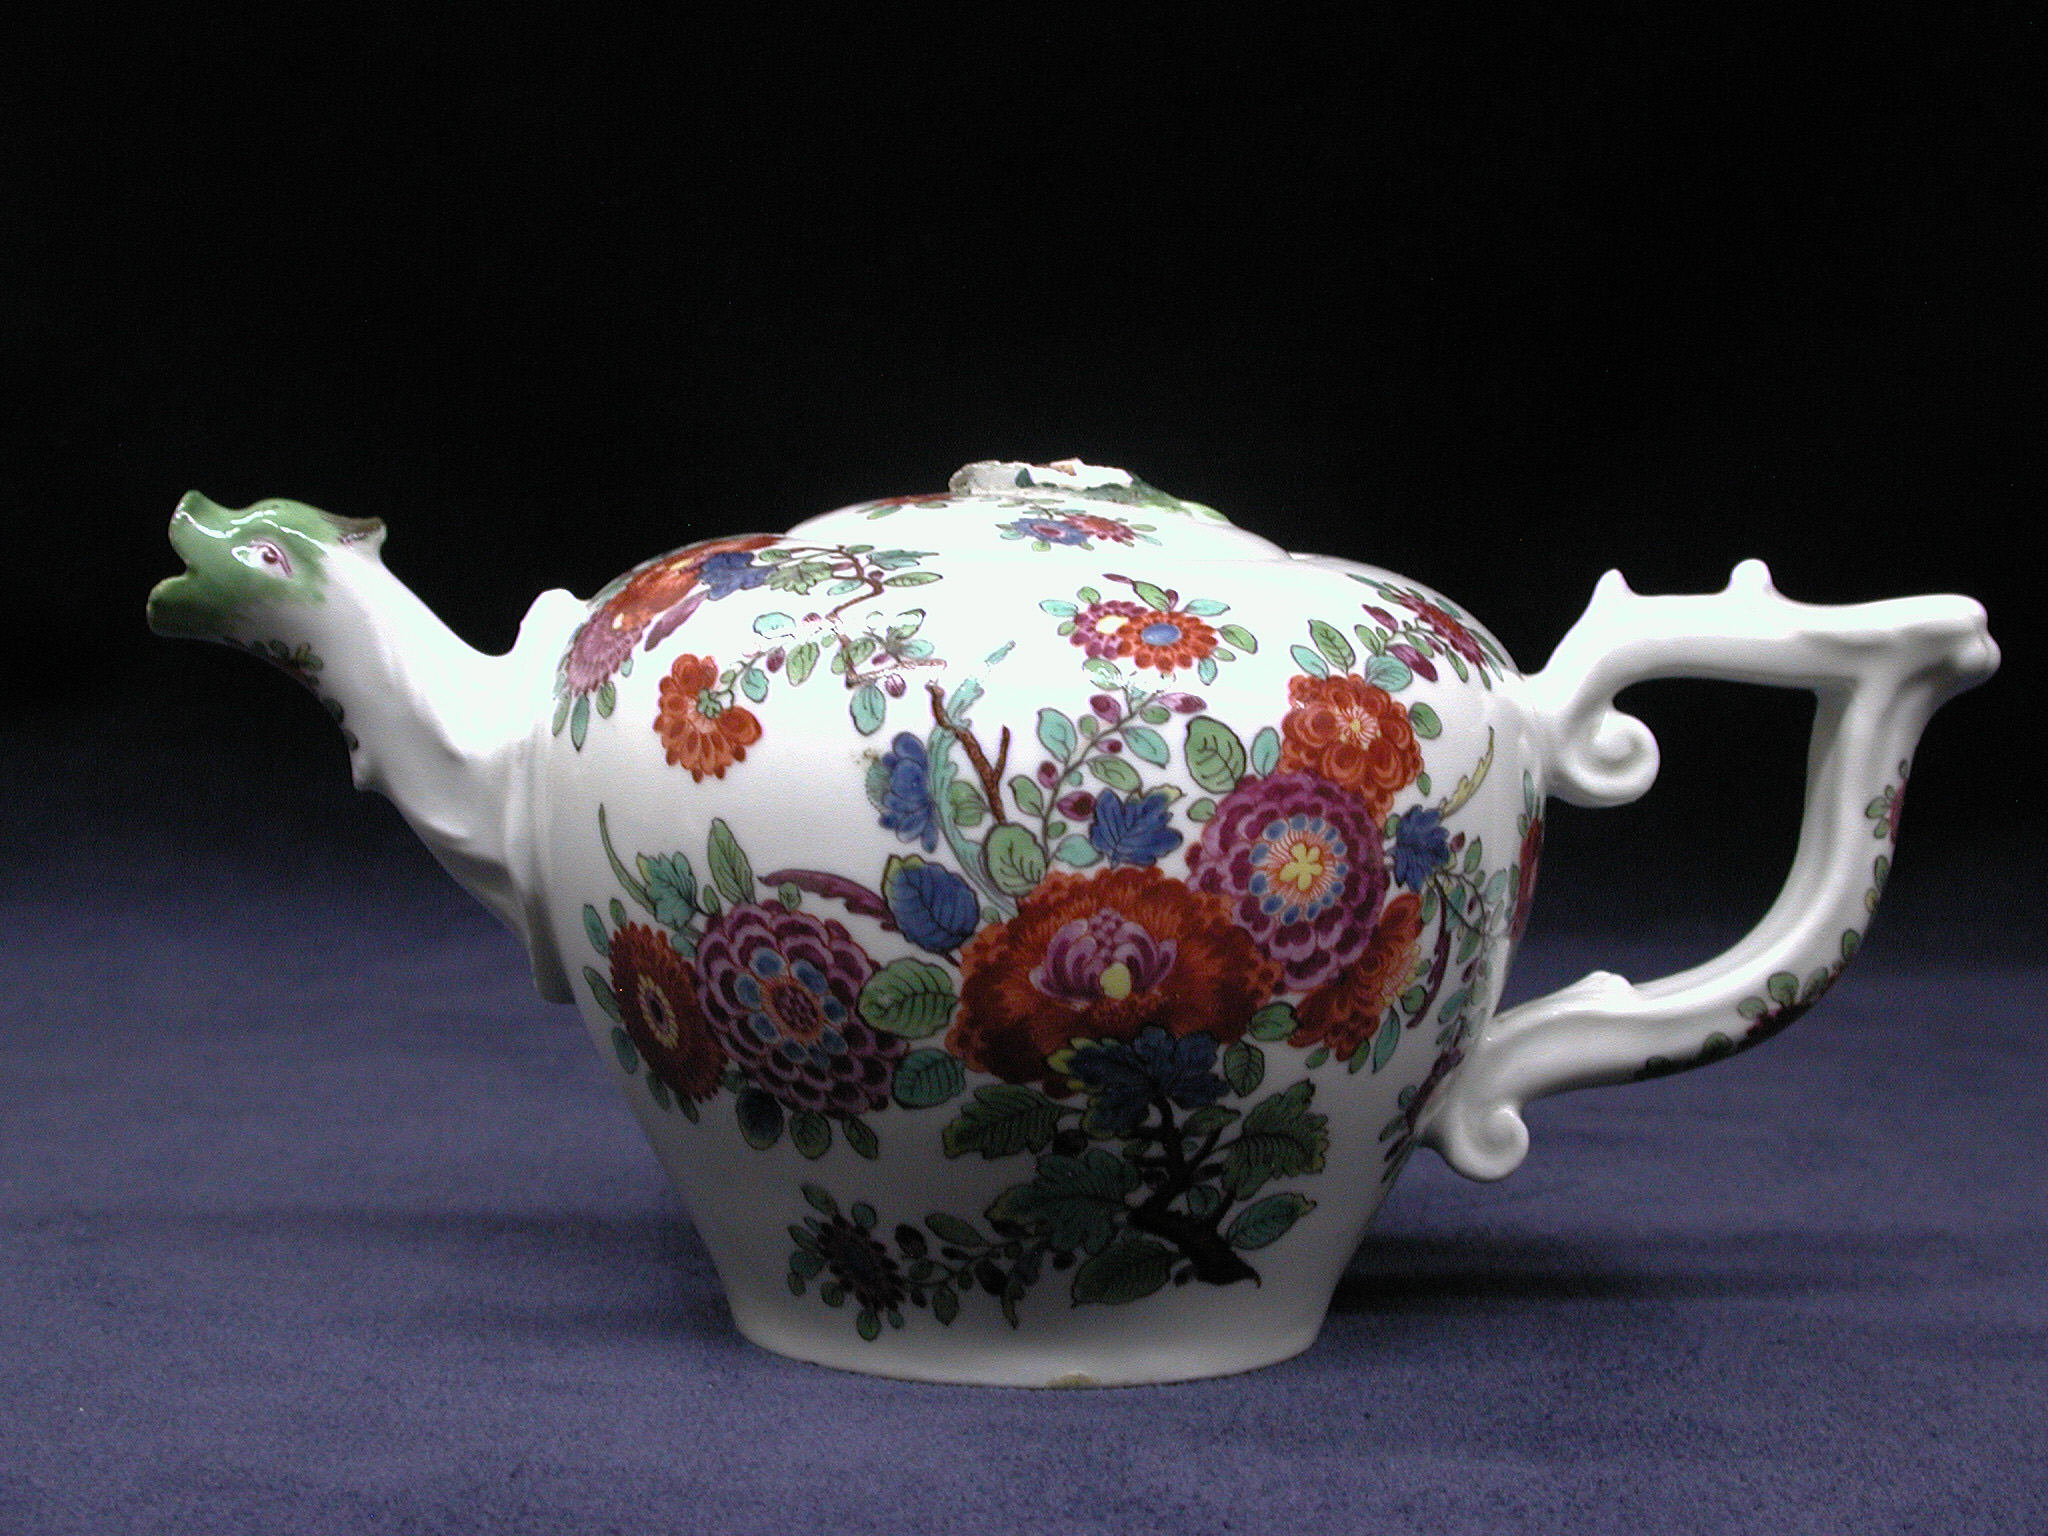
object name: teapot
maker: imperial porcelain manufactory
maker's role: manufactory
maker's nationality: austrian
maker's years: 1744-1864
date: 1750-1755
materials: hard paste porcelain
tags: animals,flowers